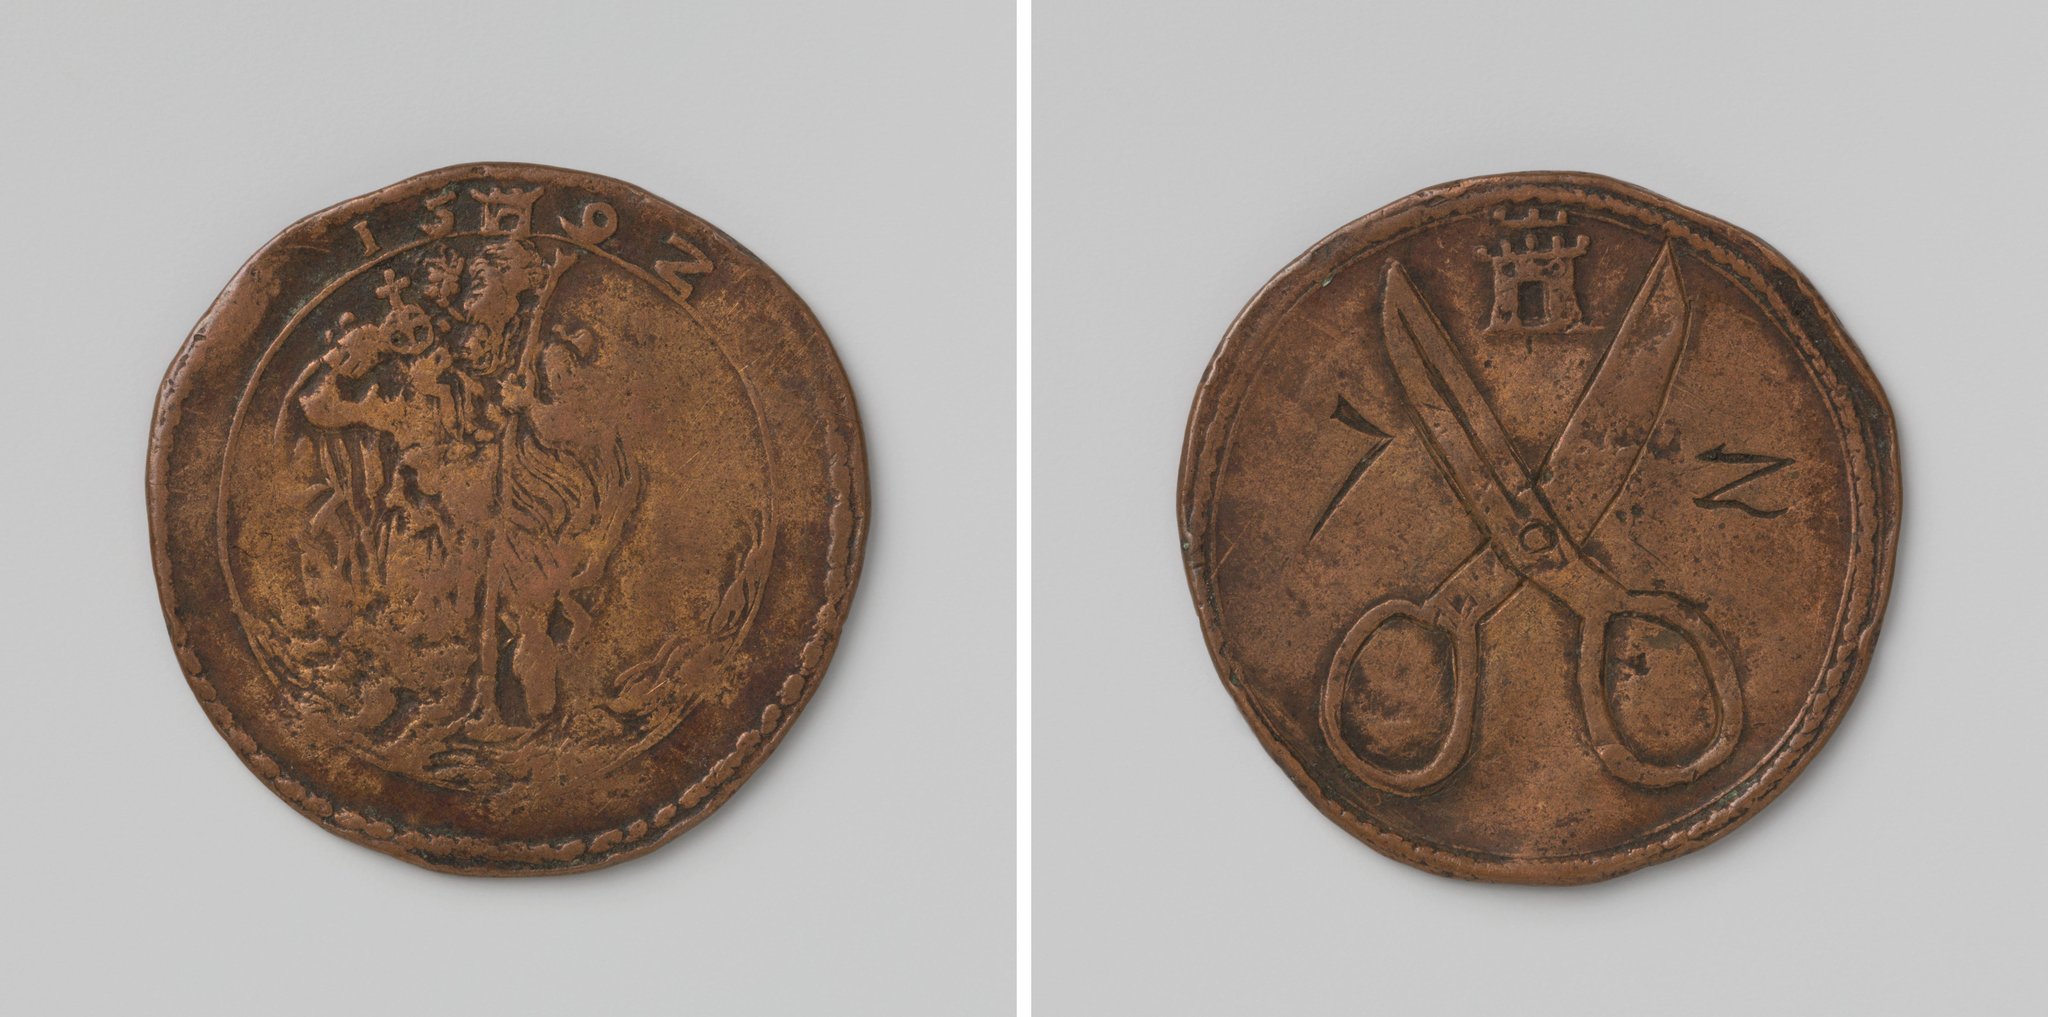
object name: medal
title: Kleermakersgilde van Middelburg, gildepenning met no. 72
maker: Anonymous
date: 1592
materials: copper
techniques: engraving, striking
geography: middelburg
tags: middelburg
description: Koperen penning. Voorzijde: St. Christophorus draagt op zijn nek Christuskind met wereldbol in hand door water onder jaartal. Keerzijde: geopende schaar, geflankeerd door de cijfers 7 en 2 onder burcht